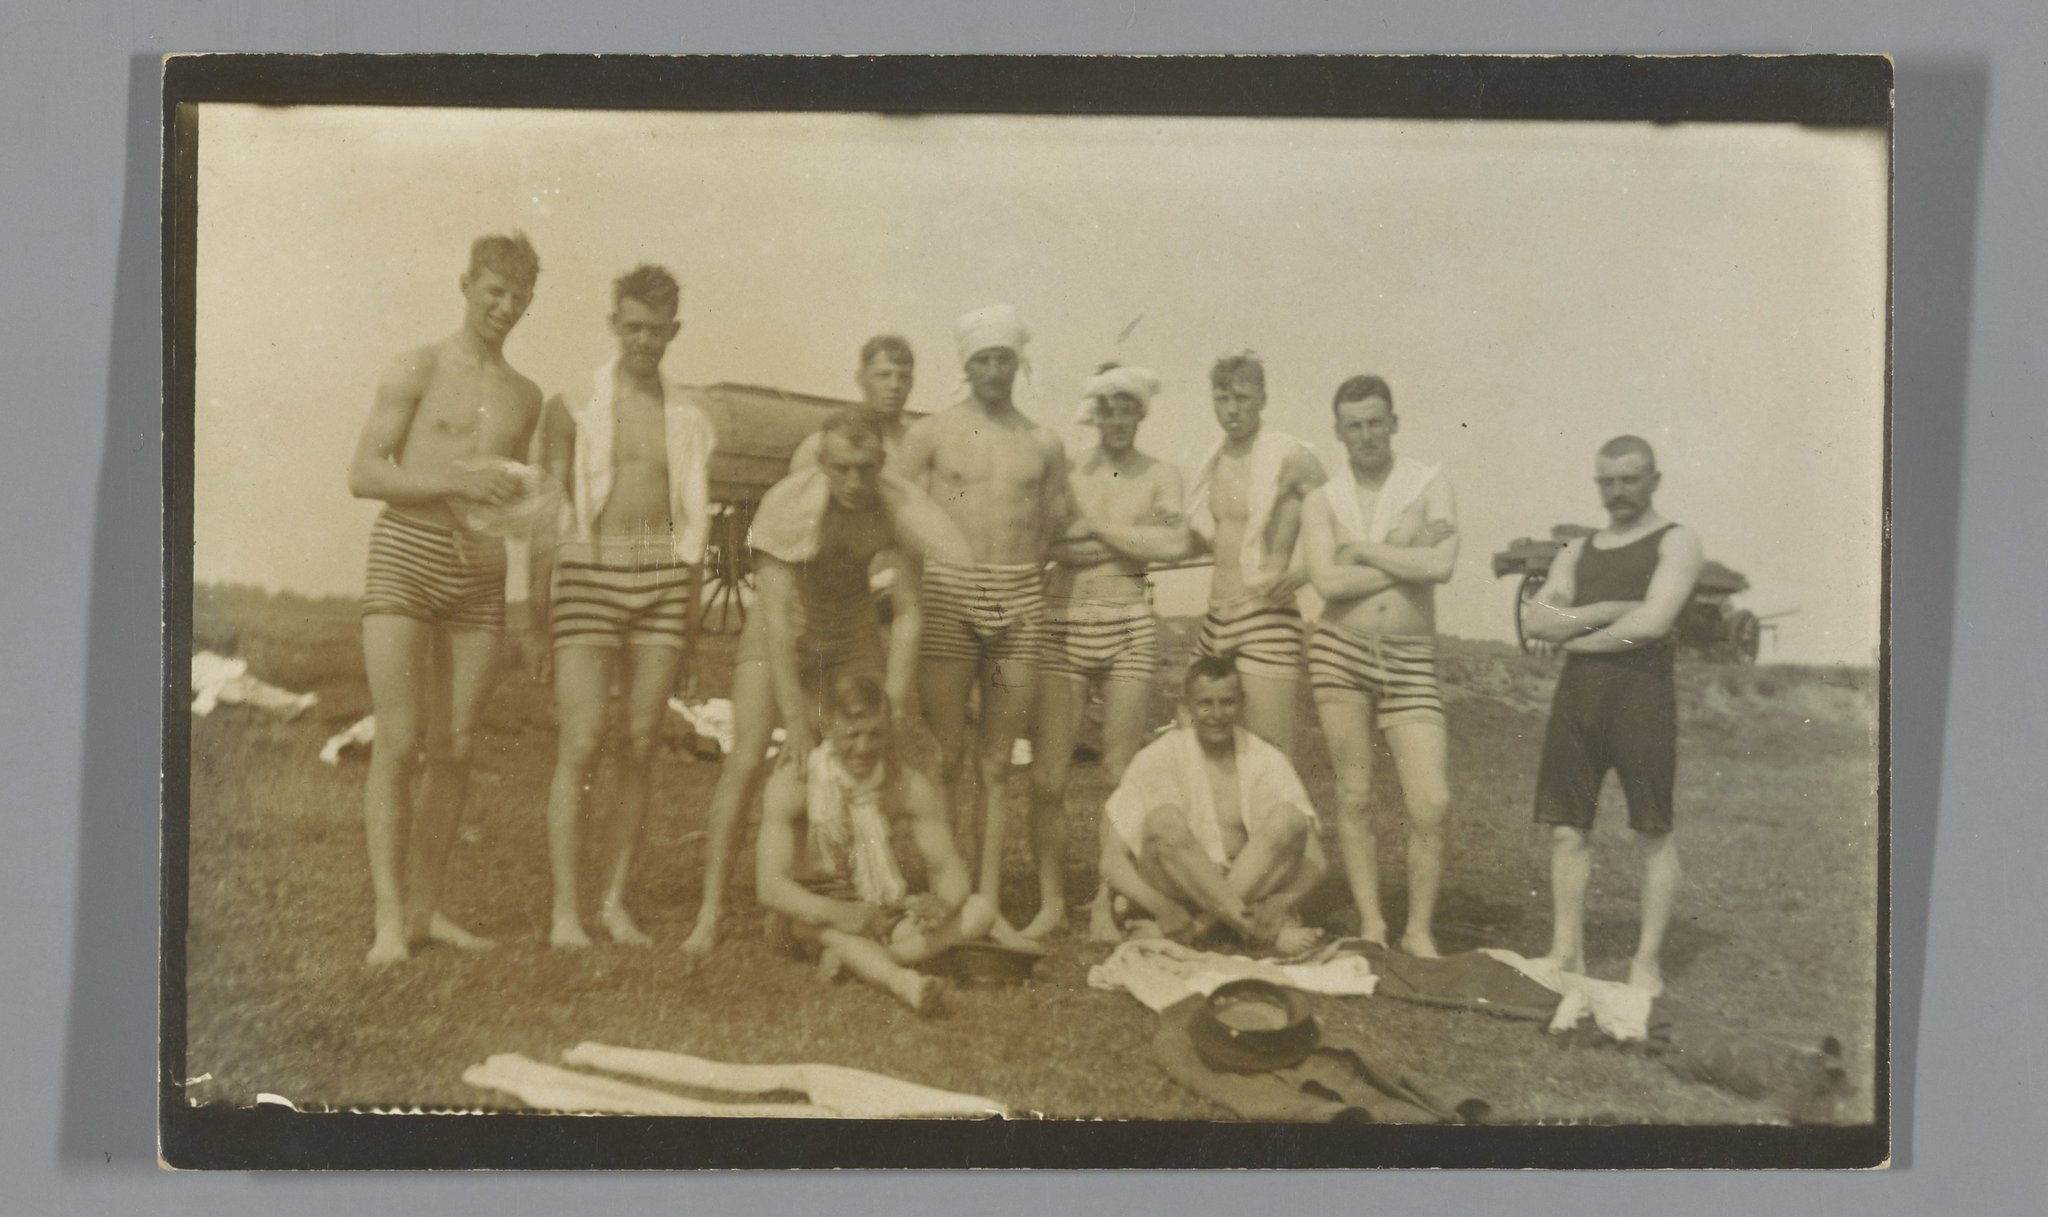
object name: ansichtkaart, prentbriefkaart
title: Groepsportret van onbekende mannen in zwemkleding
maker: Anonymous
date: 1910-1940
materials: photographic support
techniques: gelatin silver print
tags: anonymous historical persons portrayed in a group, in a group-portrait